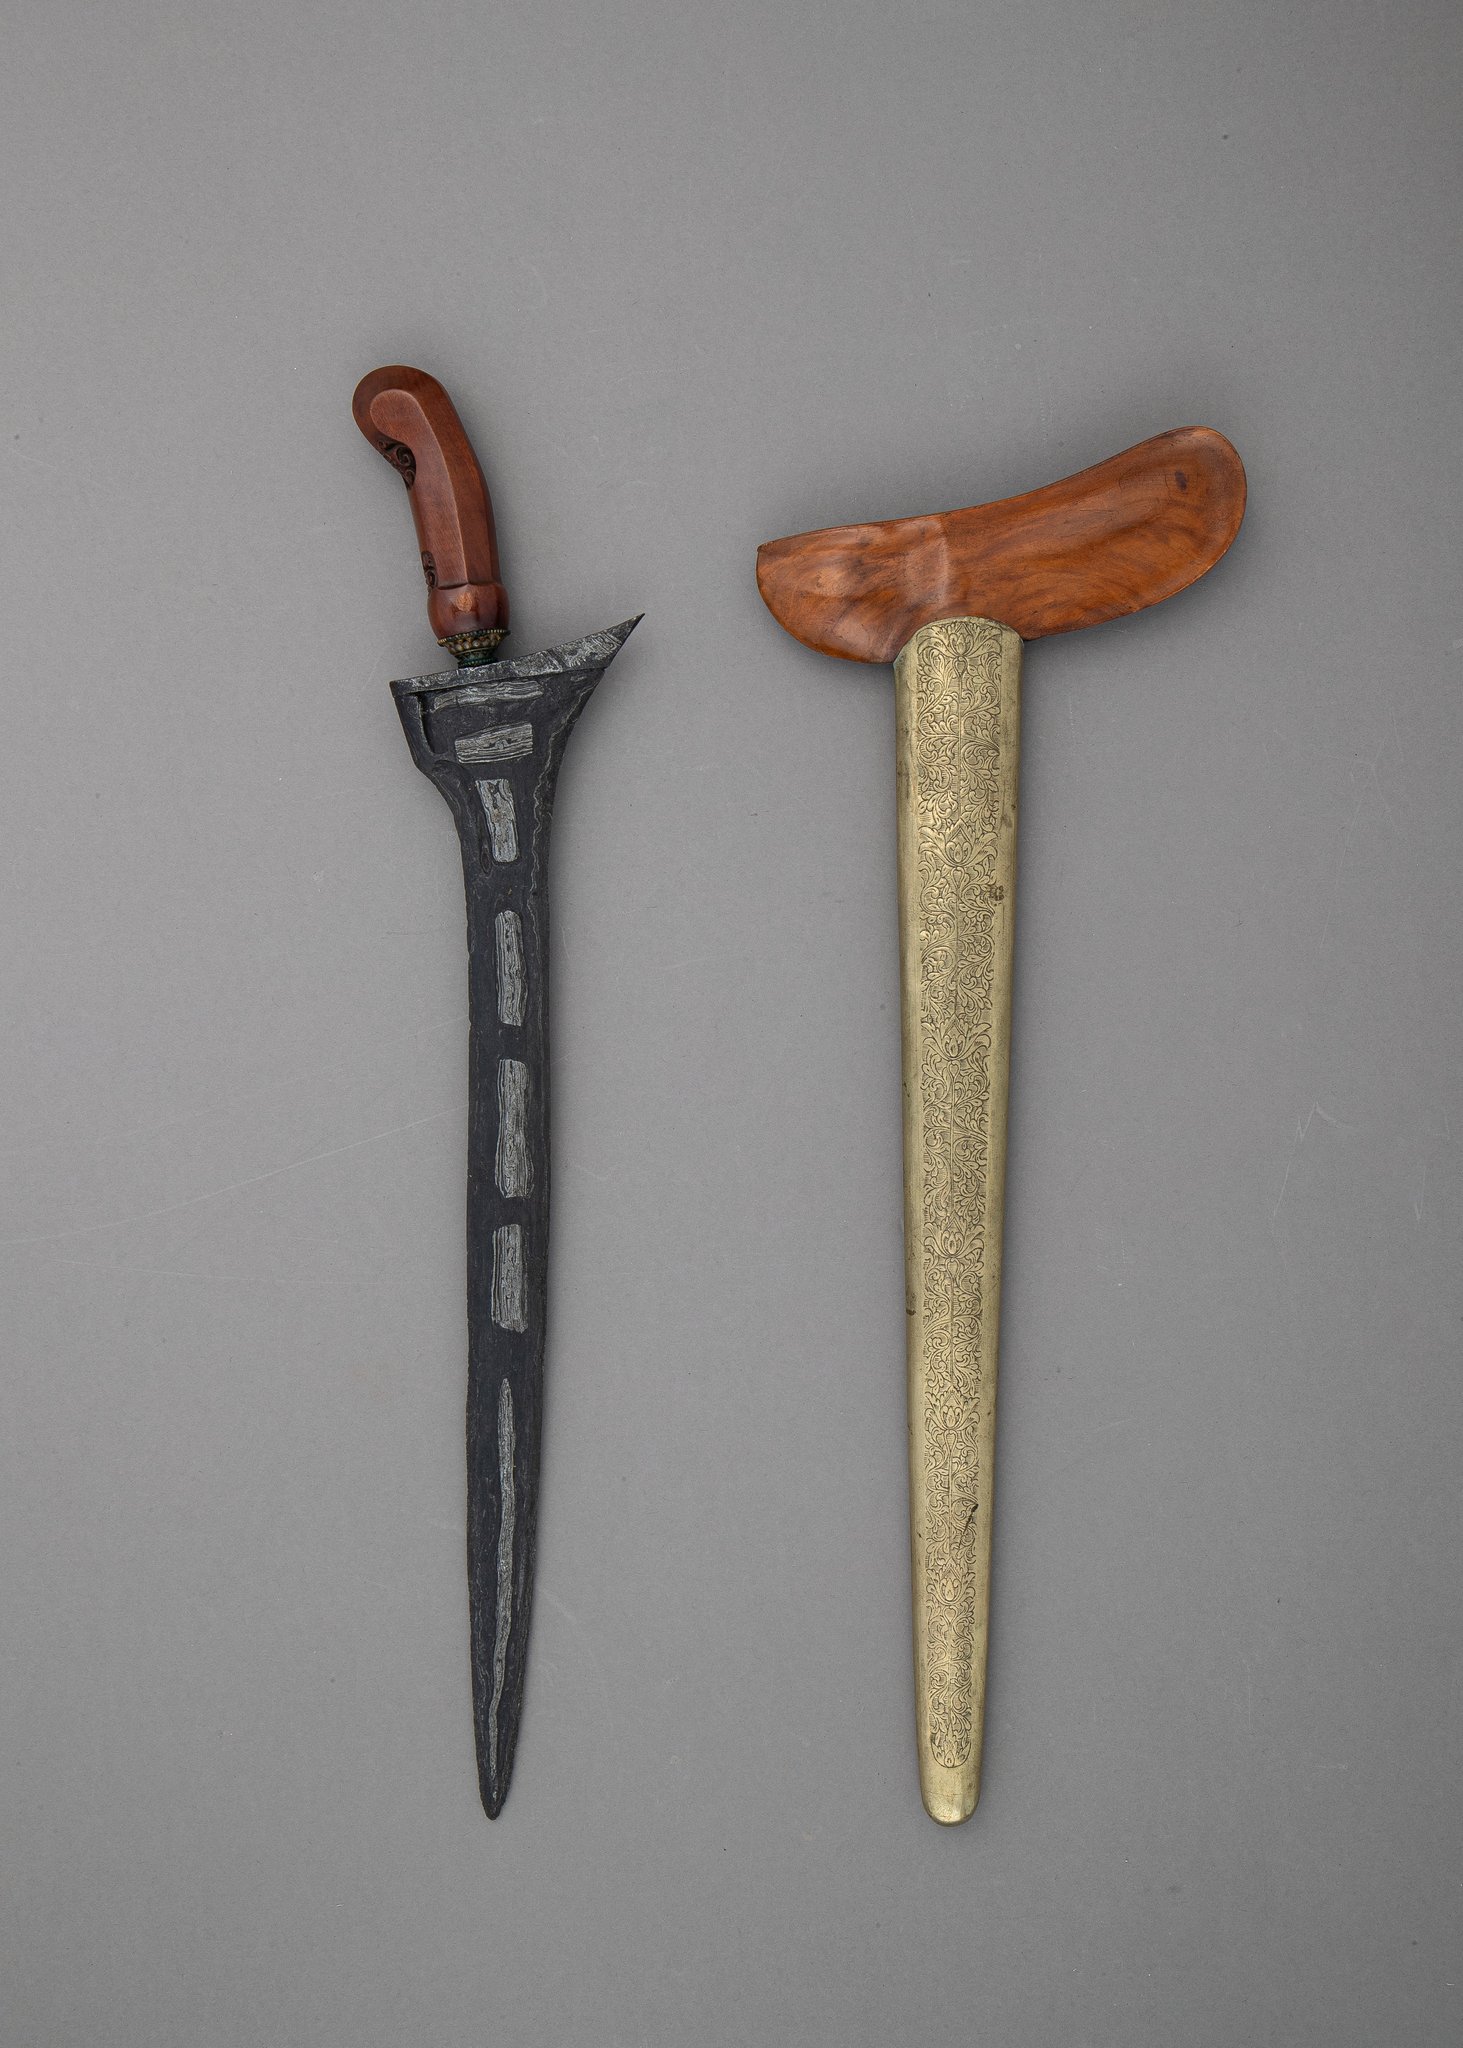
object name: kris with sheath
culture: javanese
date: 1501-1900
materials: brass, steel, wood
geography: indonesia